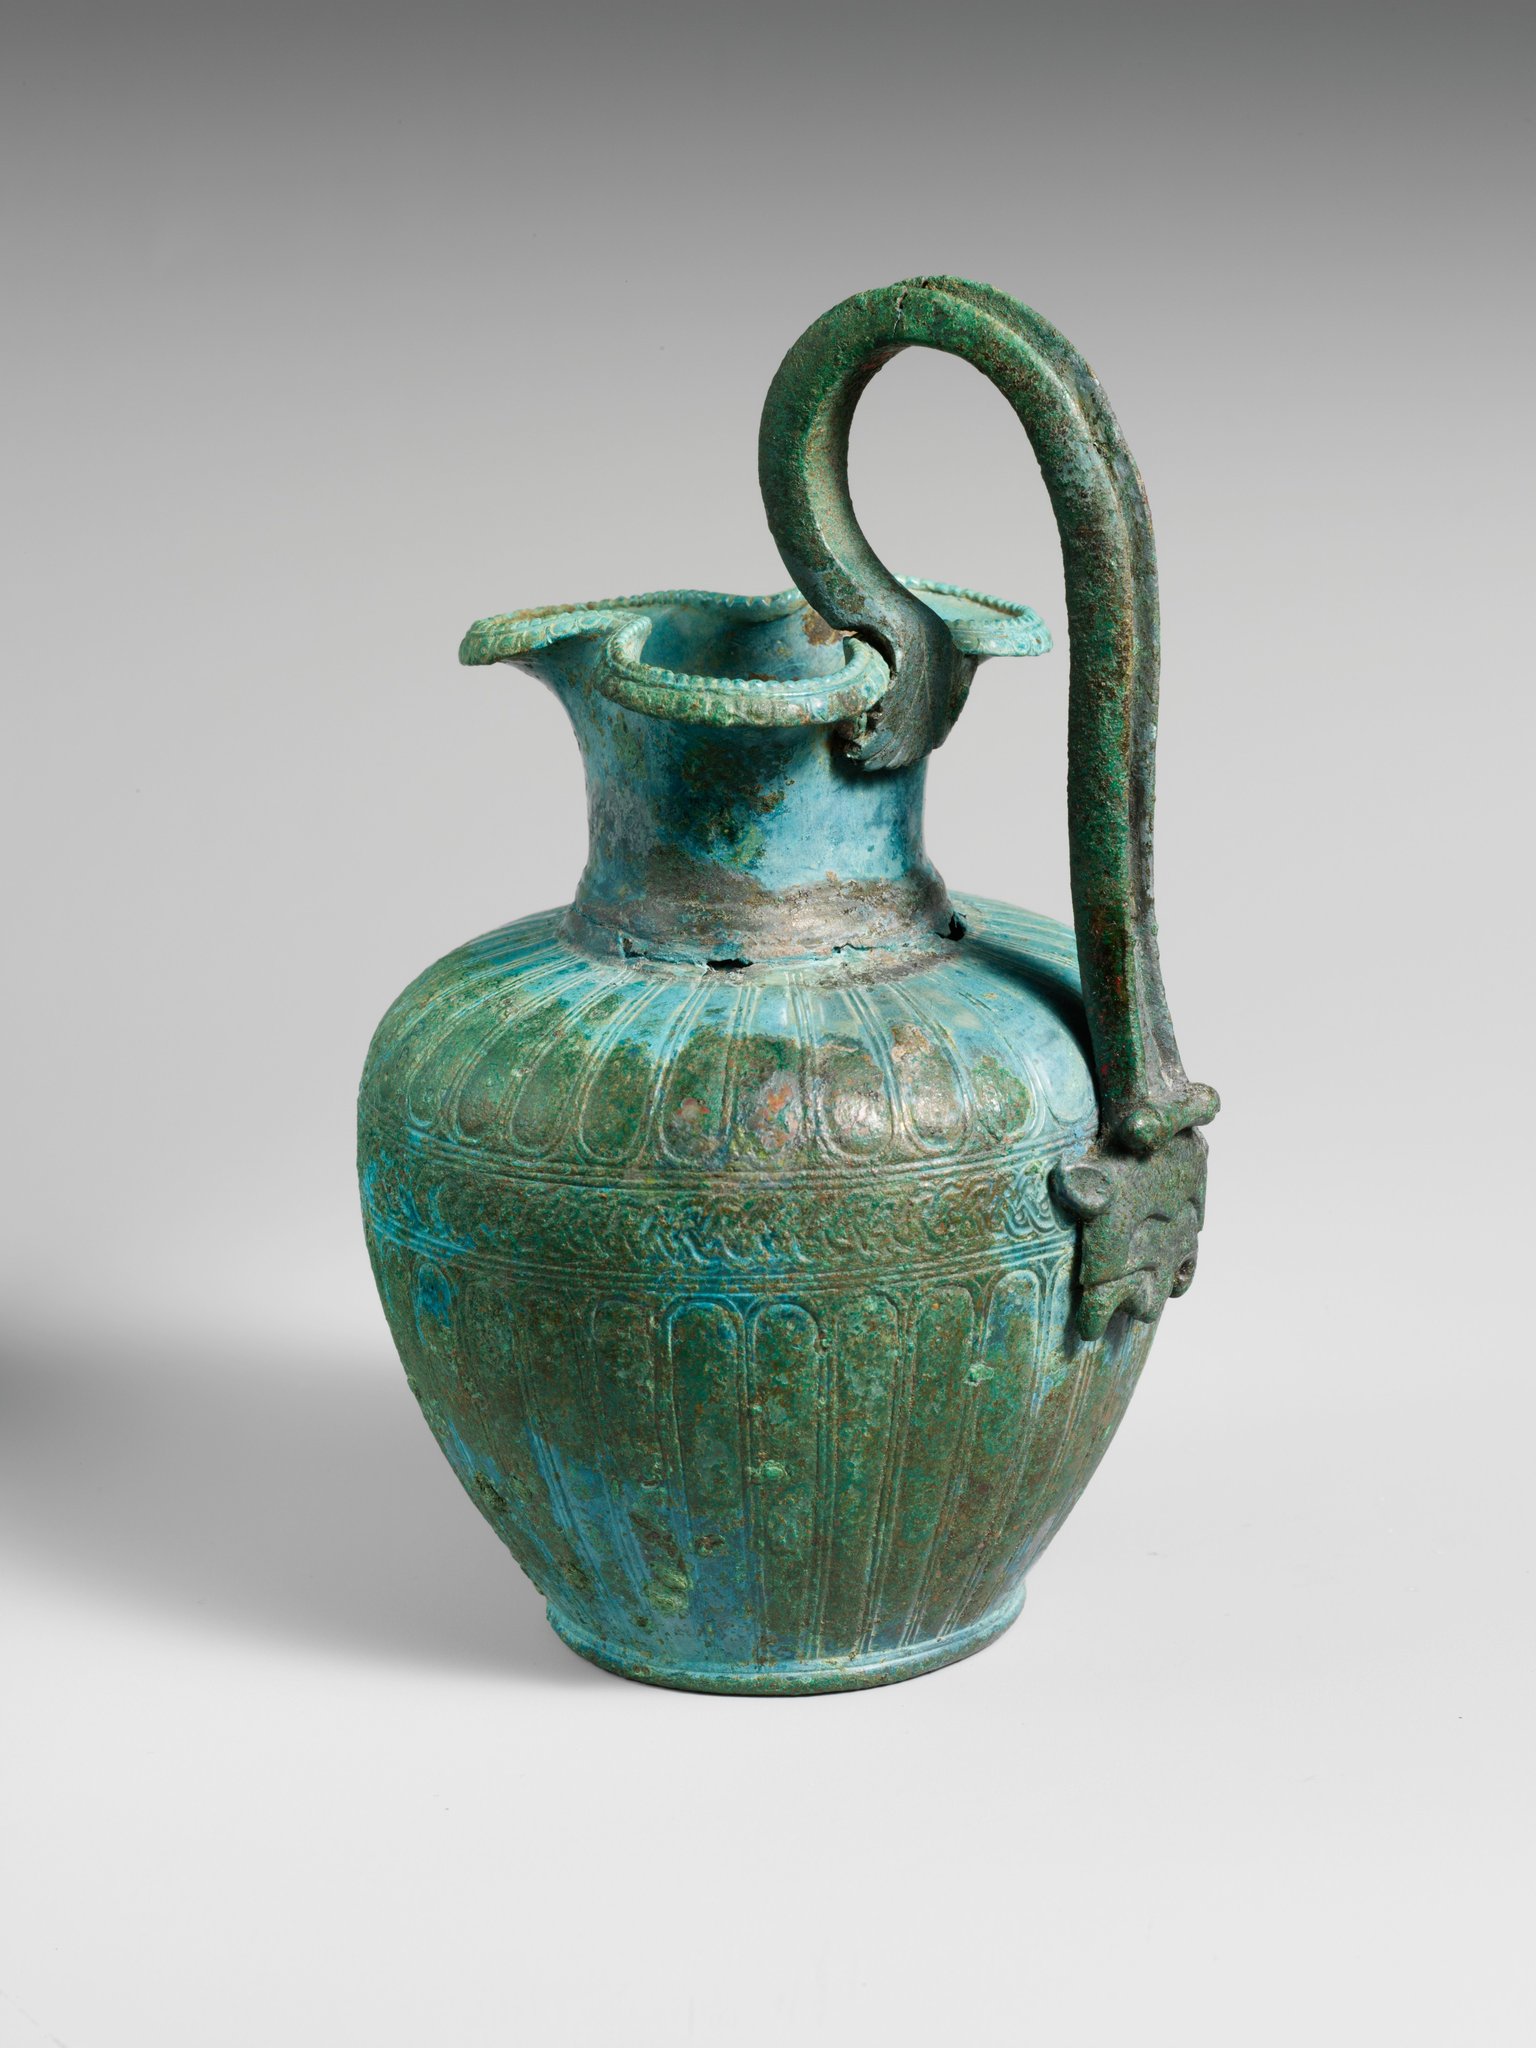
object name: oinochoe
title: Bronze oinochoe (jug)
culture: etruscan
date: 500-401 BCE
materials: bronze